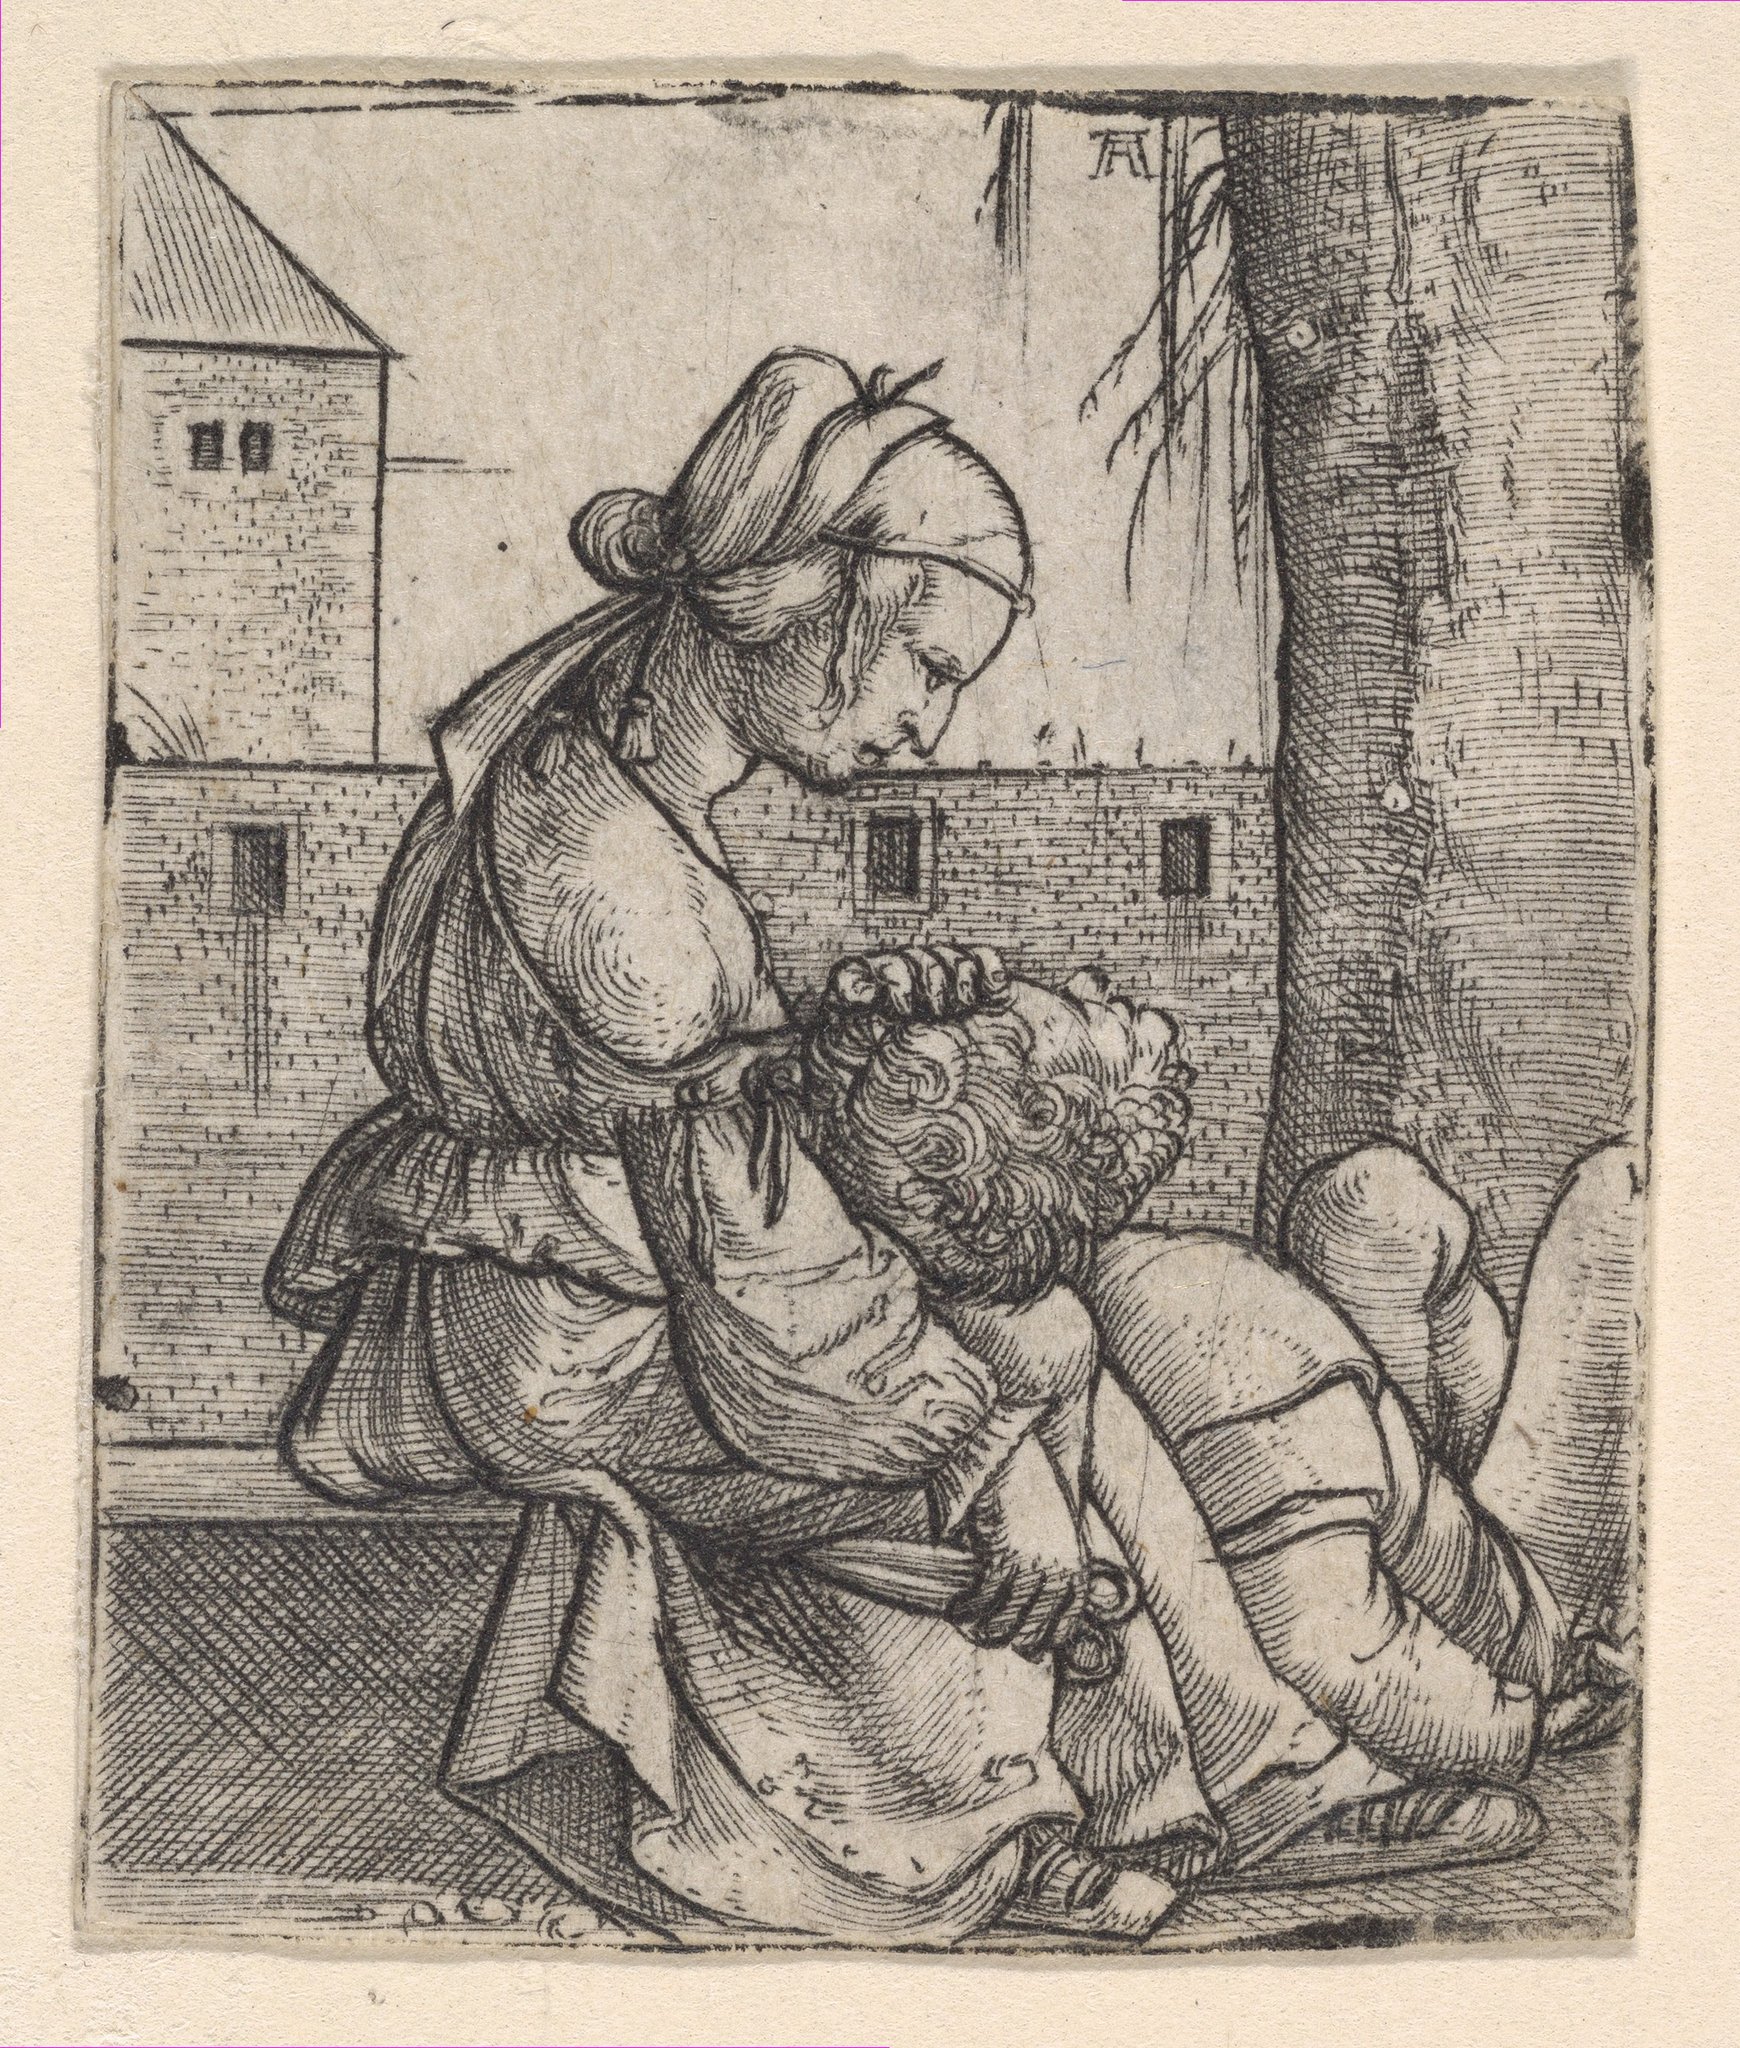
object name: print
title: Samson and Delilah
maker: albrecht altdorfer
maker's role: artist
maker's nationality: german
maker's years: 1480-1538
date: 1500-1538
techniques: engraving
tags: women,samson